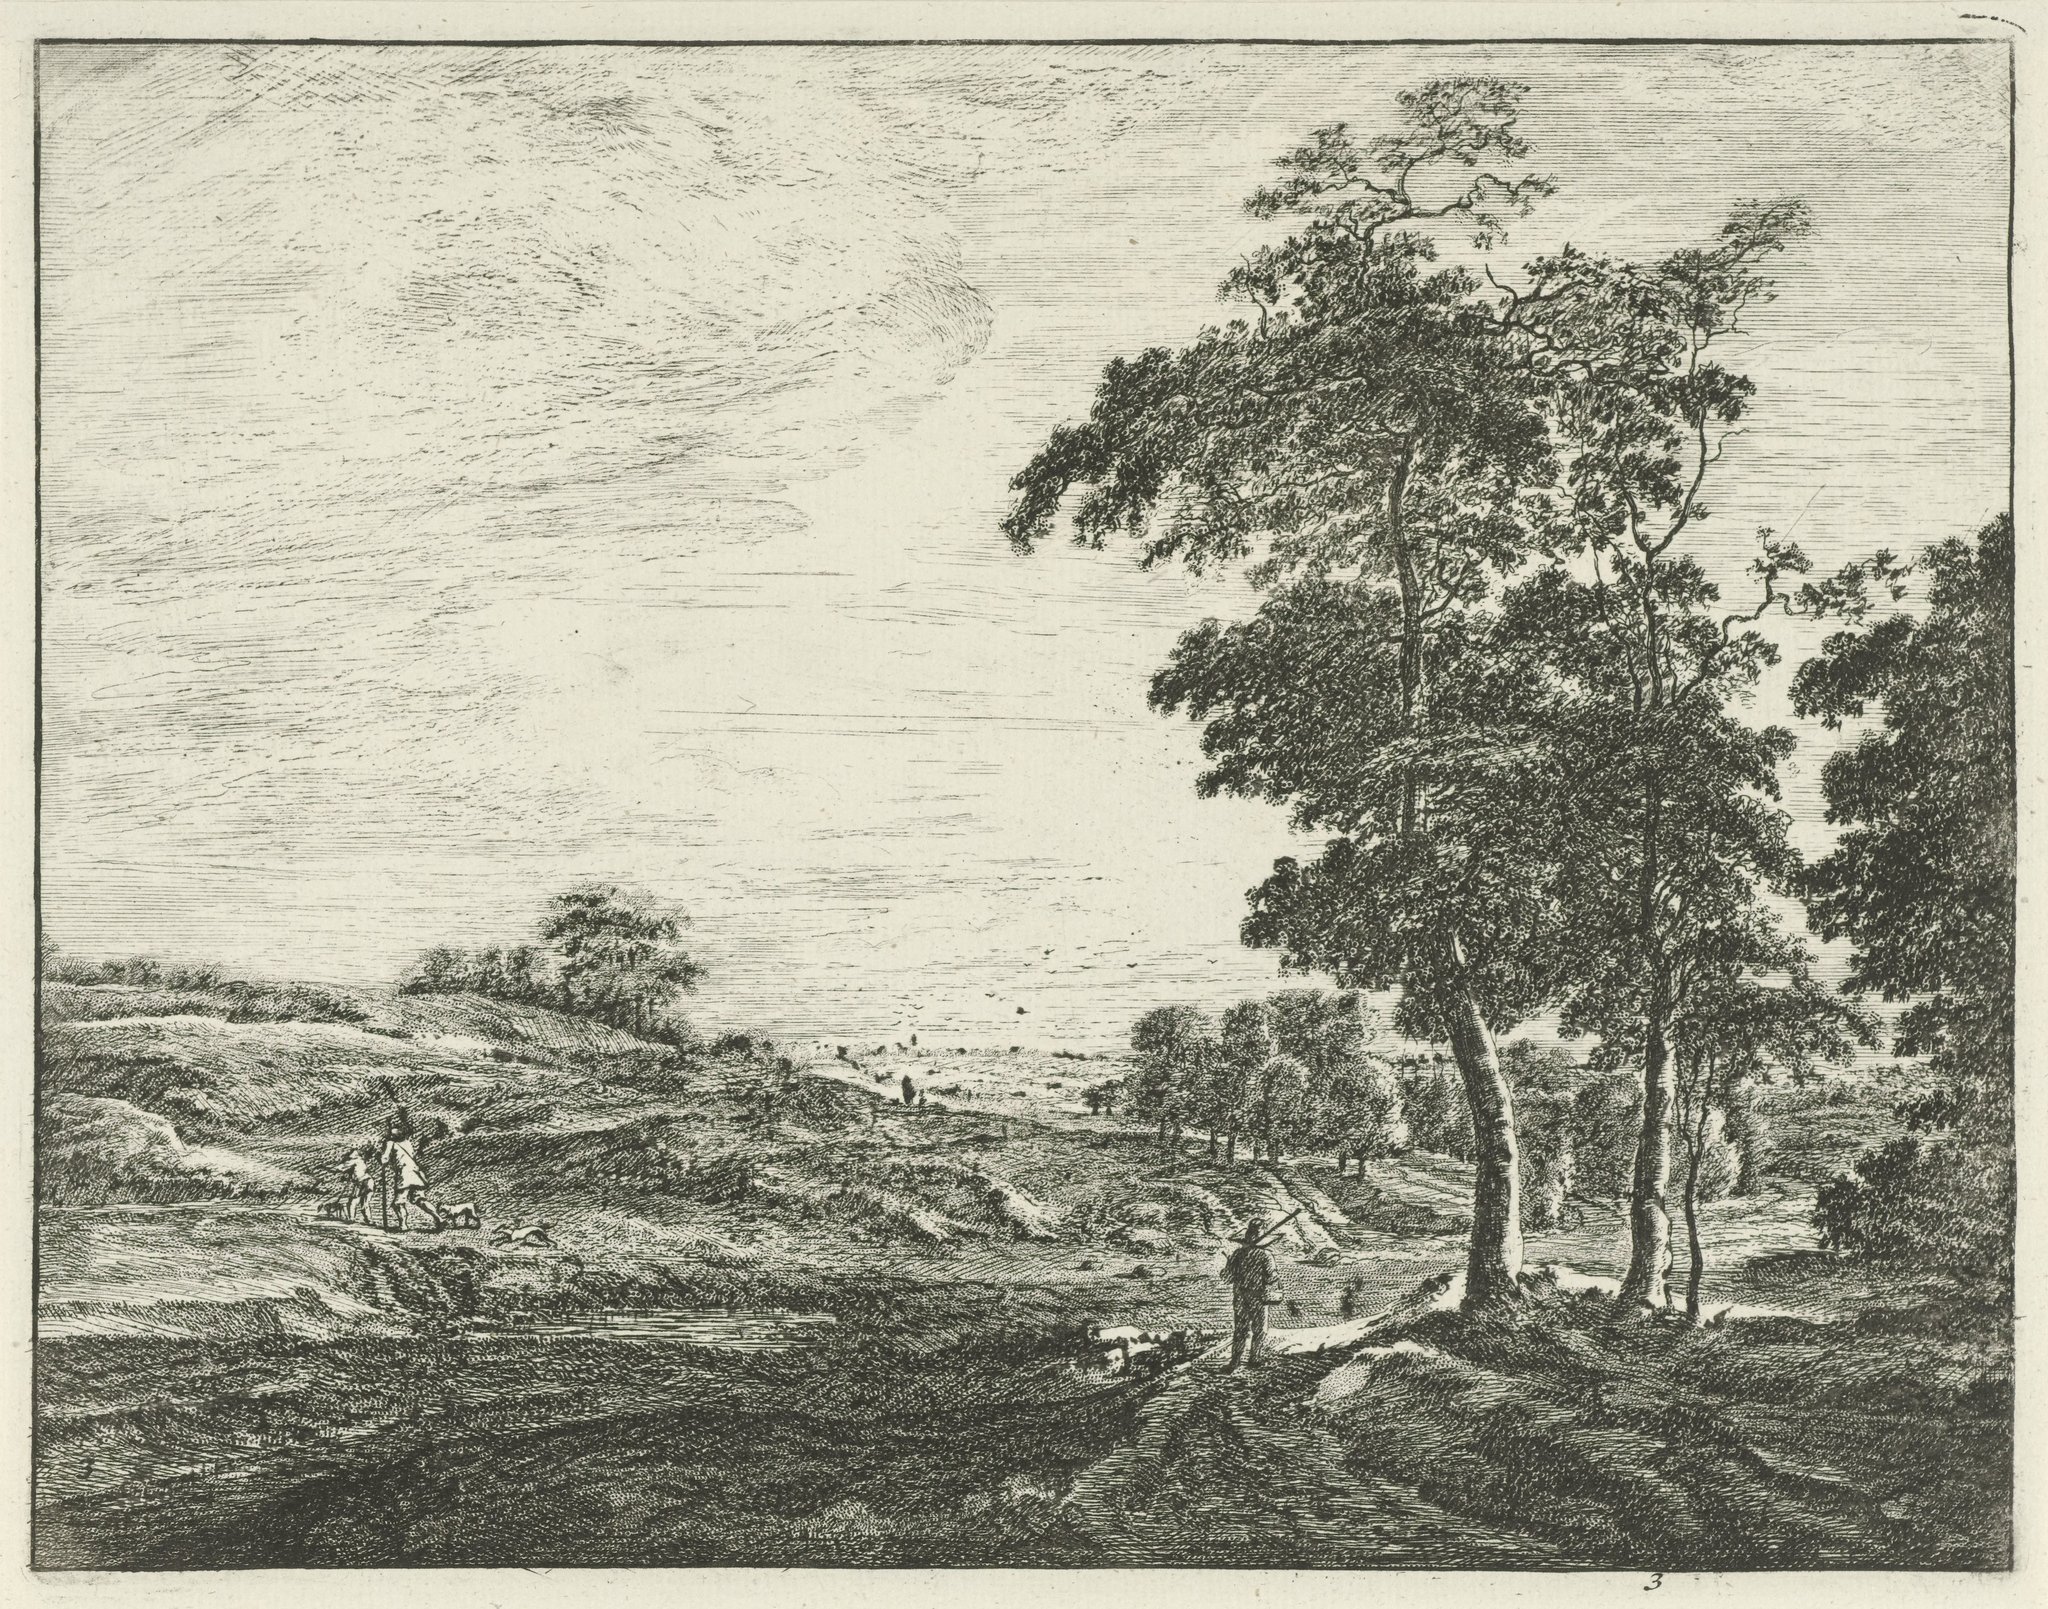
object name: print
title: Aan de rand van het Haagse Bos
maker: roelant roghman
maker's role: draughtsman, painter, print maker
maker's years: 1627-1692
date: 1637-1742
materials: paper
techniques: etching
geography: amsterdam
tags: low hill country, forest, wood, dog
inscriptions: collector's mark: Lugt 2228a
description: Gezicht op een glooiend landschap aan de rand van het Haagse Bos. Op de voorgrond een wandelaar en links twee mannen met honden.